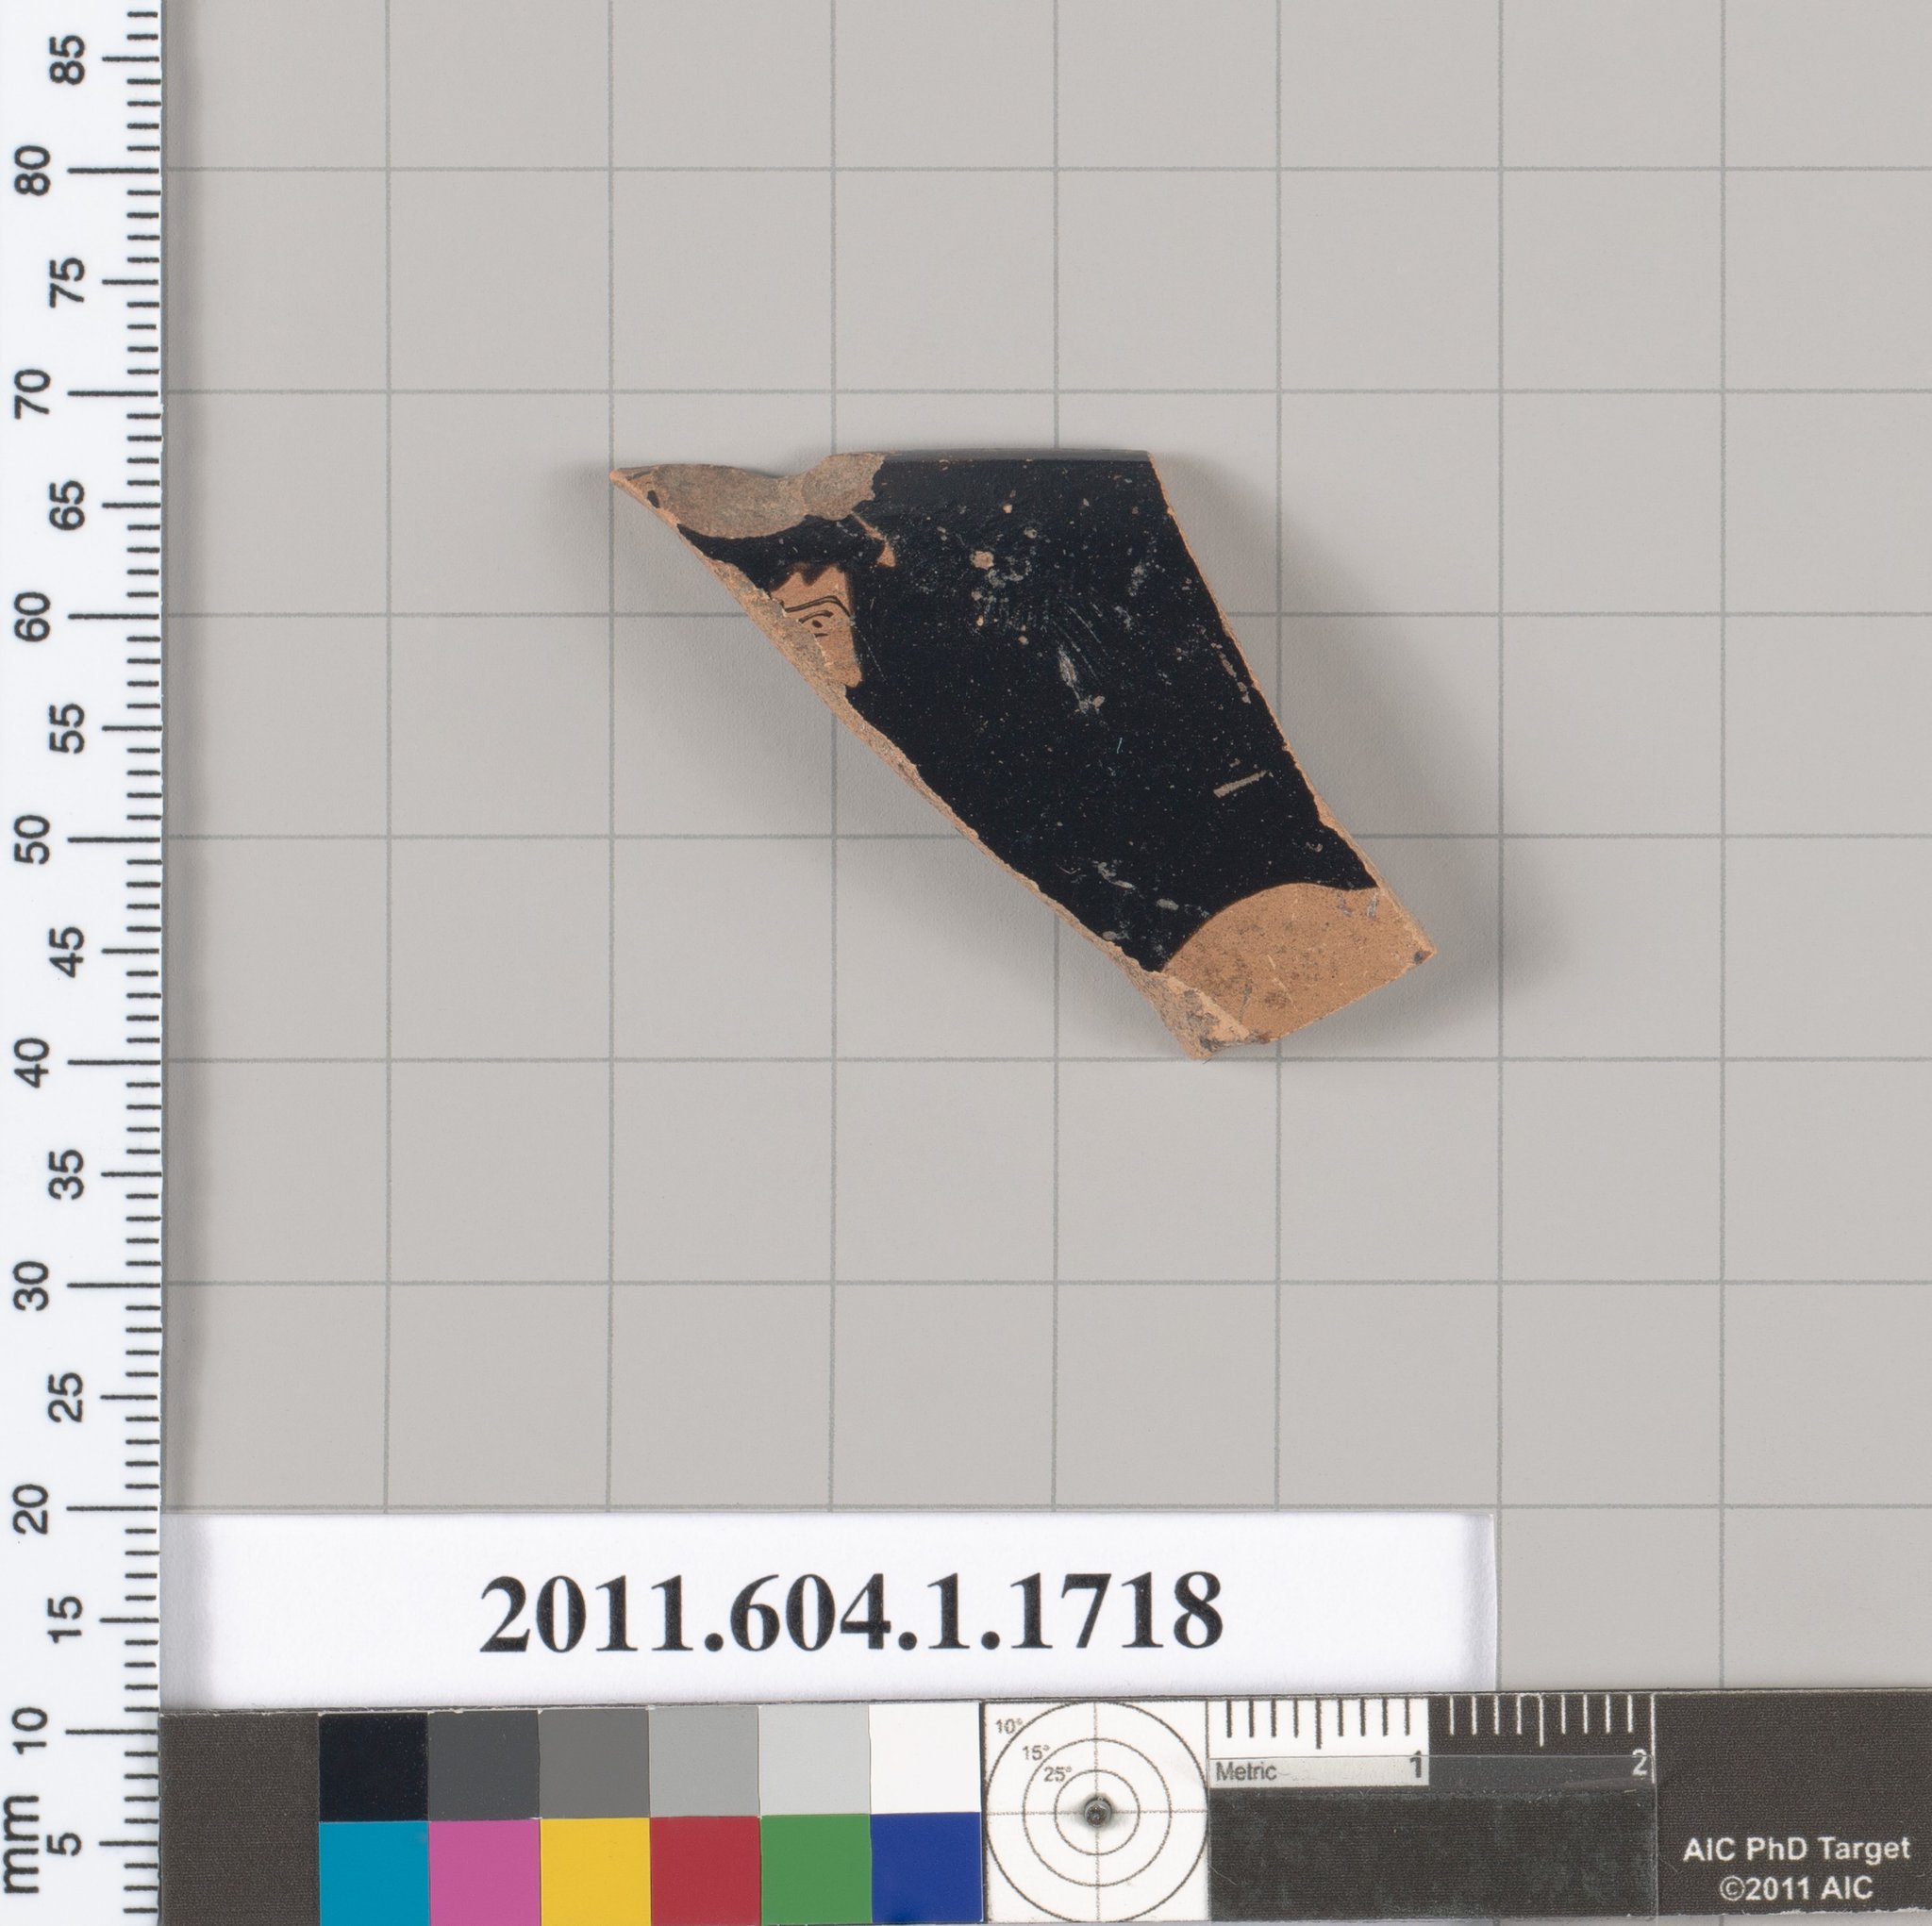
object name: kylix fragment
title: Terracotta rim fragment of a kylix (drinking cup)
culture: greek, attic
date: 475-451 BCE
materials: terracotta